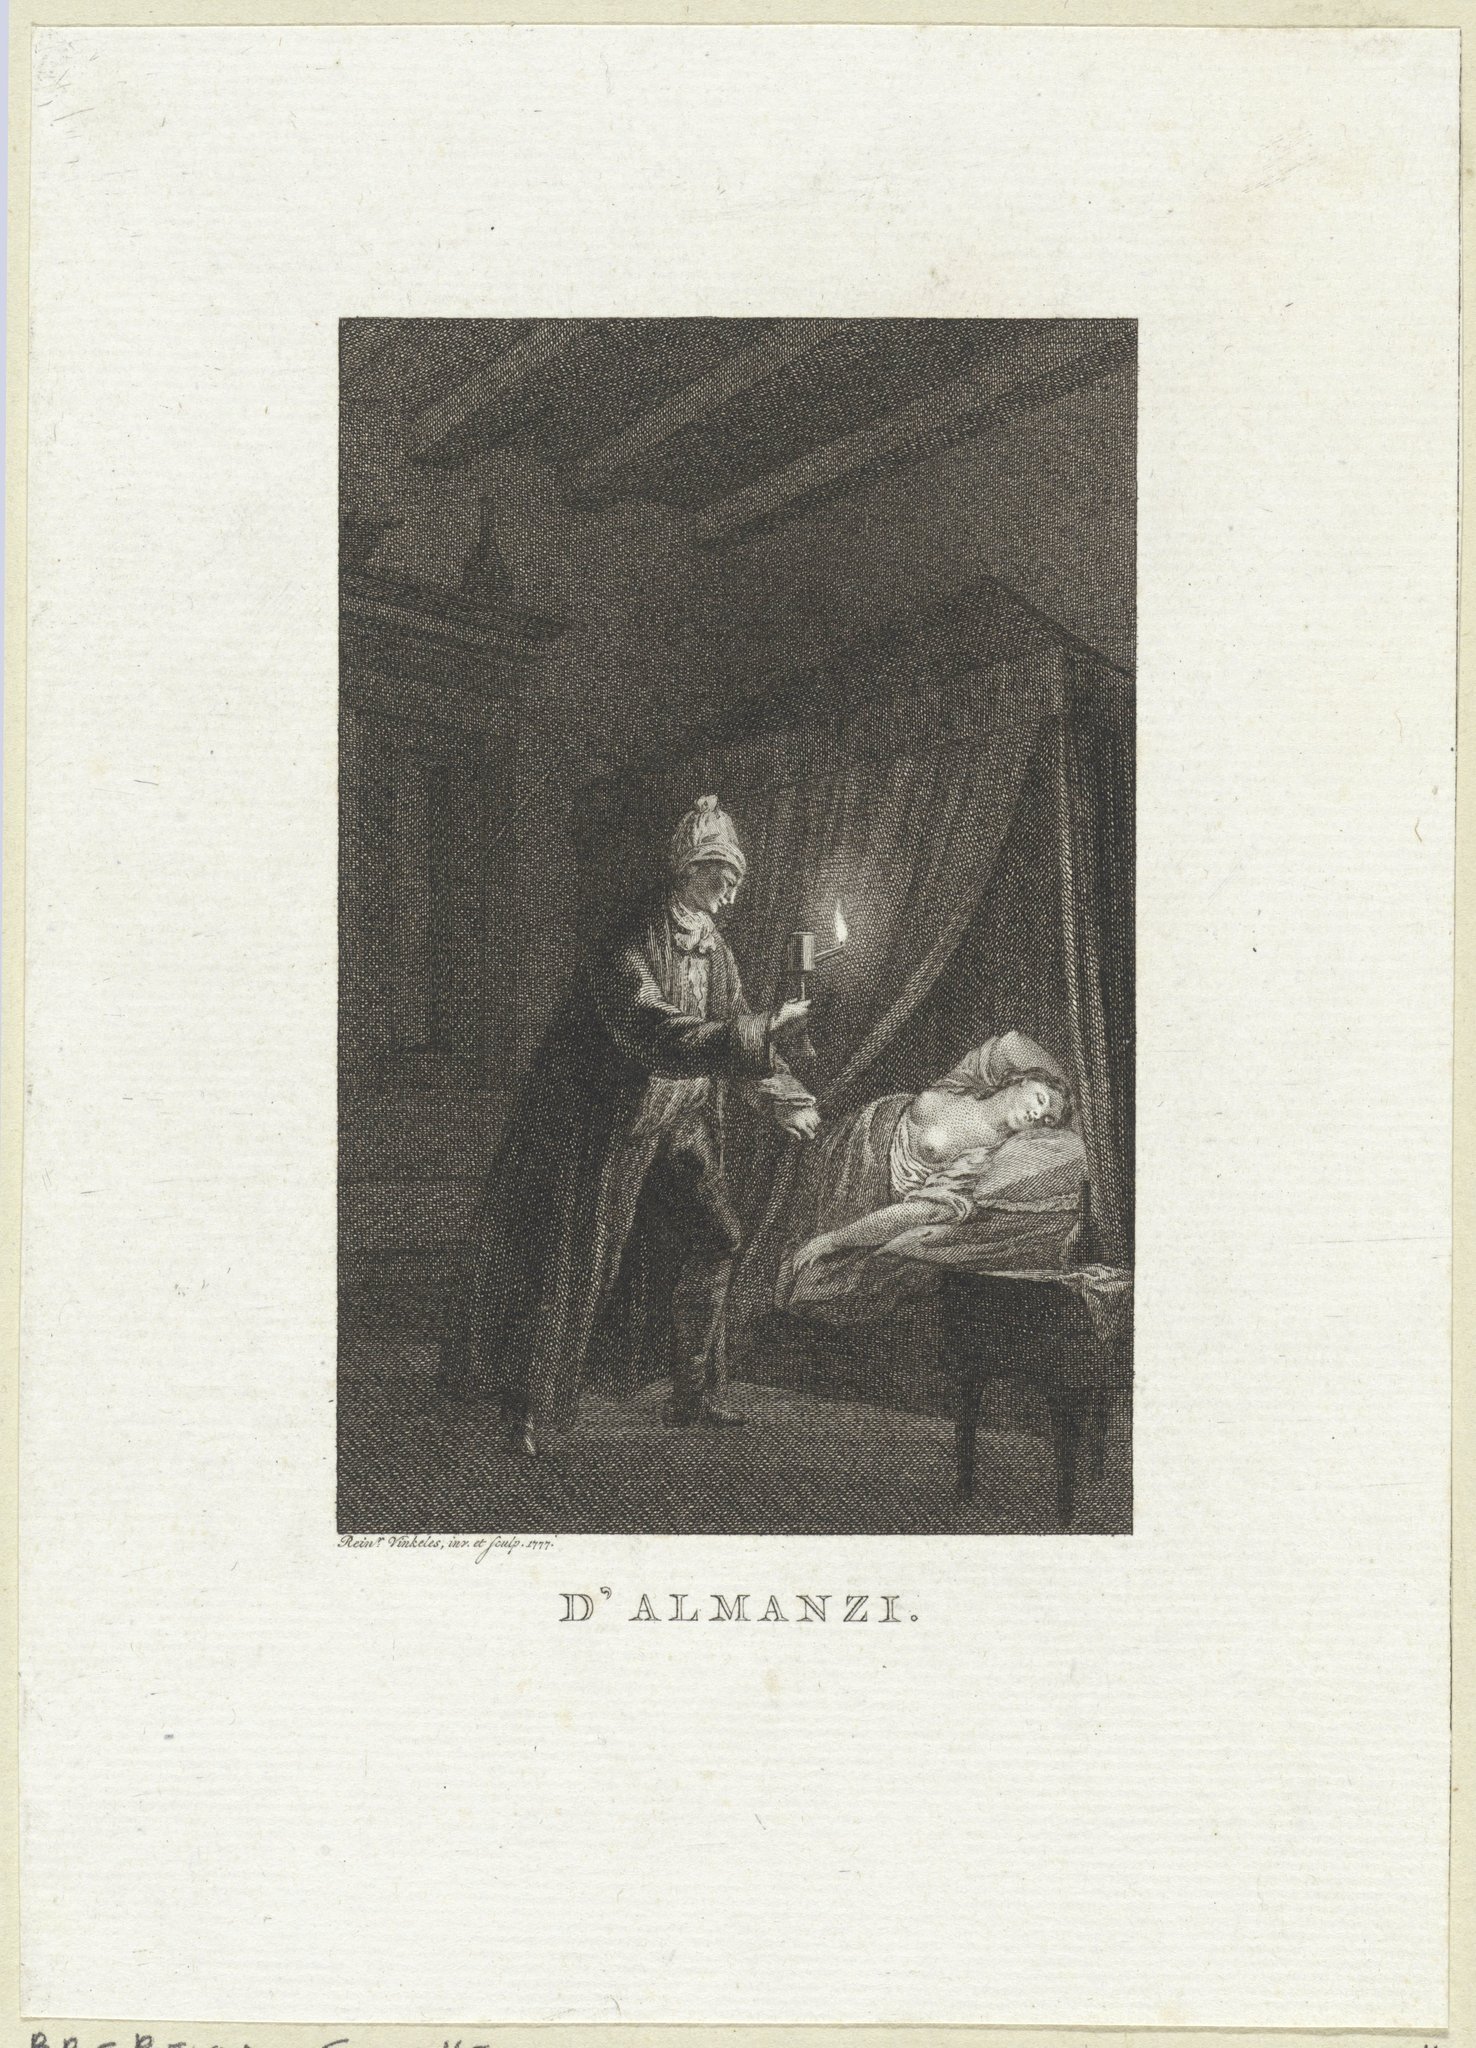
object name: print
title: Man bekijkt een vrouw met ontbloot bovenlijf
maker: reinier vinkeles (i)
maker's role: draughtsman, print maker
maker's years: 1741-1816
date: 1777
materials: paper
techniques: engraving, etching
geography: amsterdam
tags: breasts, nightwear: night-cap, oil-lamp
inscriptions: collector's mark: Lugt 240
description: Deze prent is ook gebruikt als illustratie bij het verhaal 'D'Almanzi' voor: Baculard d'Arnaud, F.T.M. de. Zedelijke verhaalen, deel 2. Amsterdam: A. Mens Jansz. en A.E. Munnikhuisen, 1777.